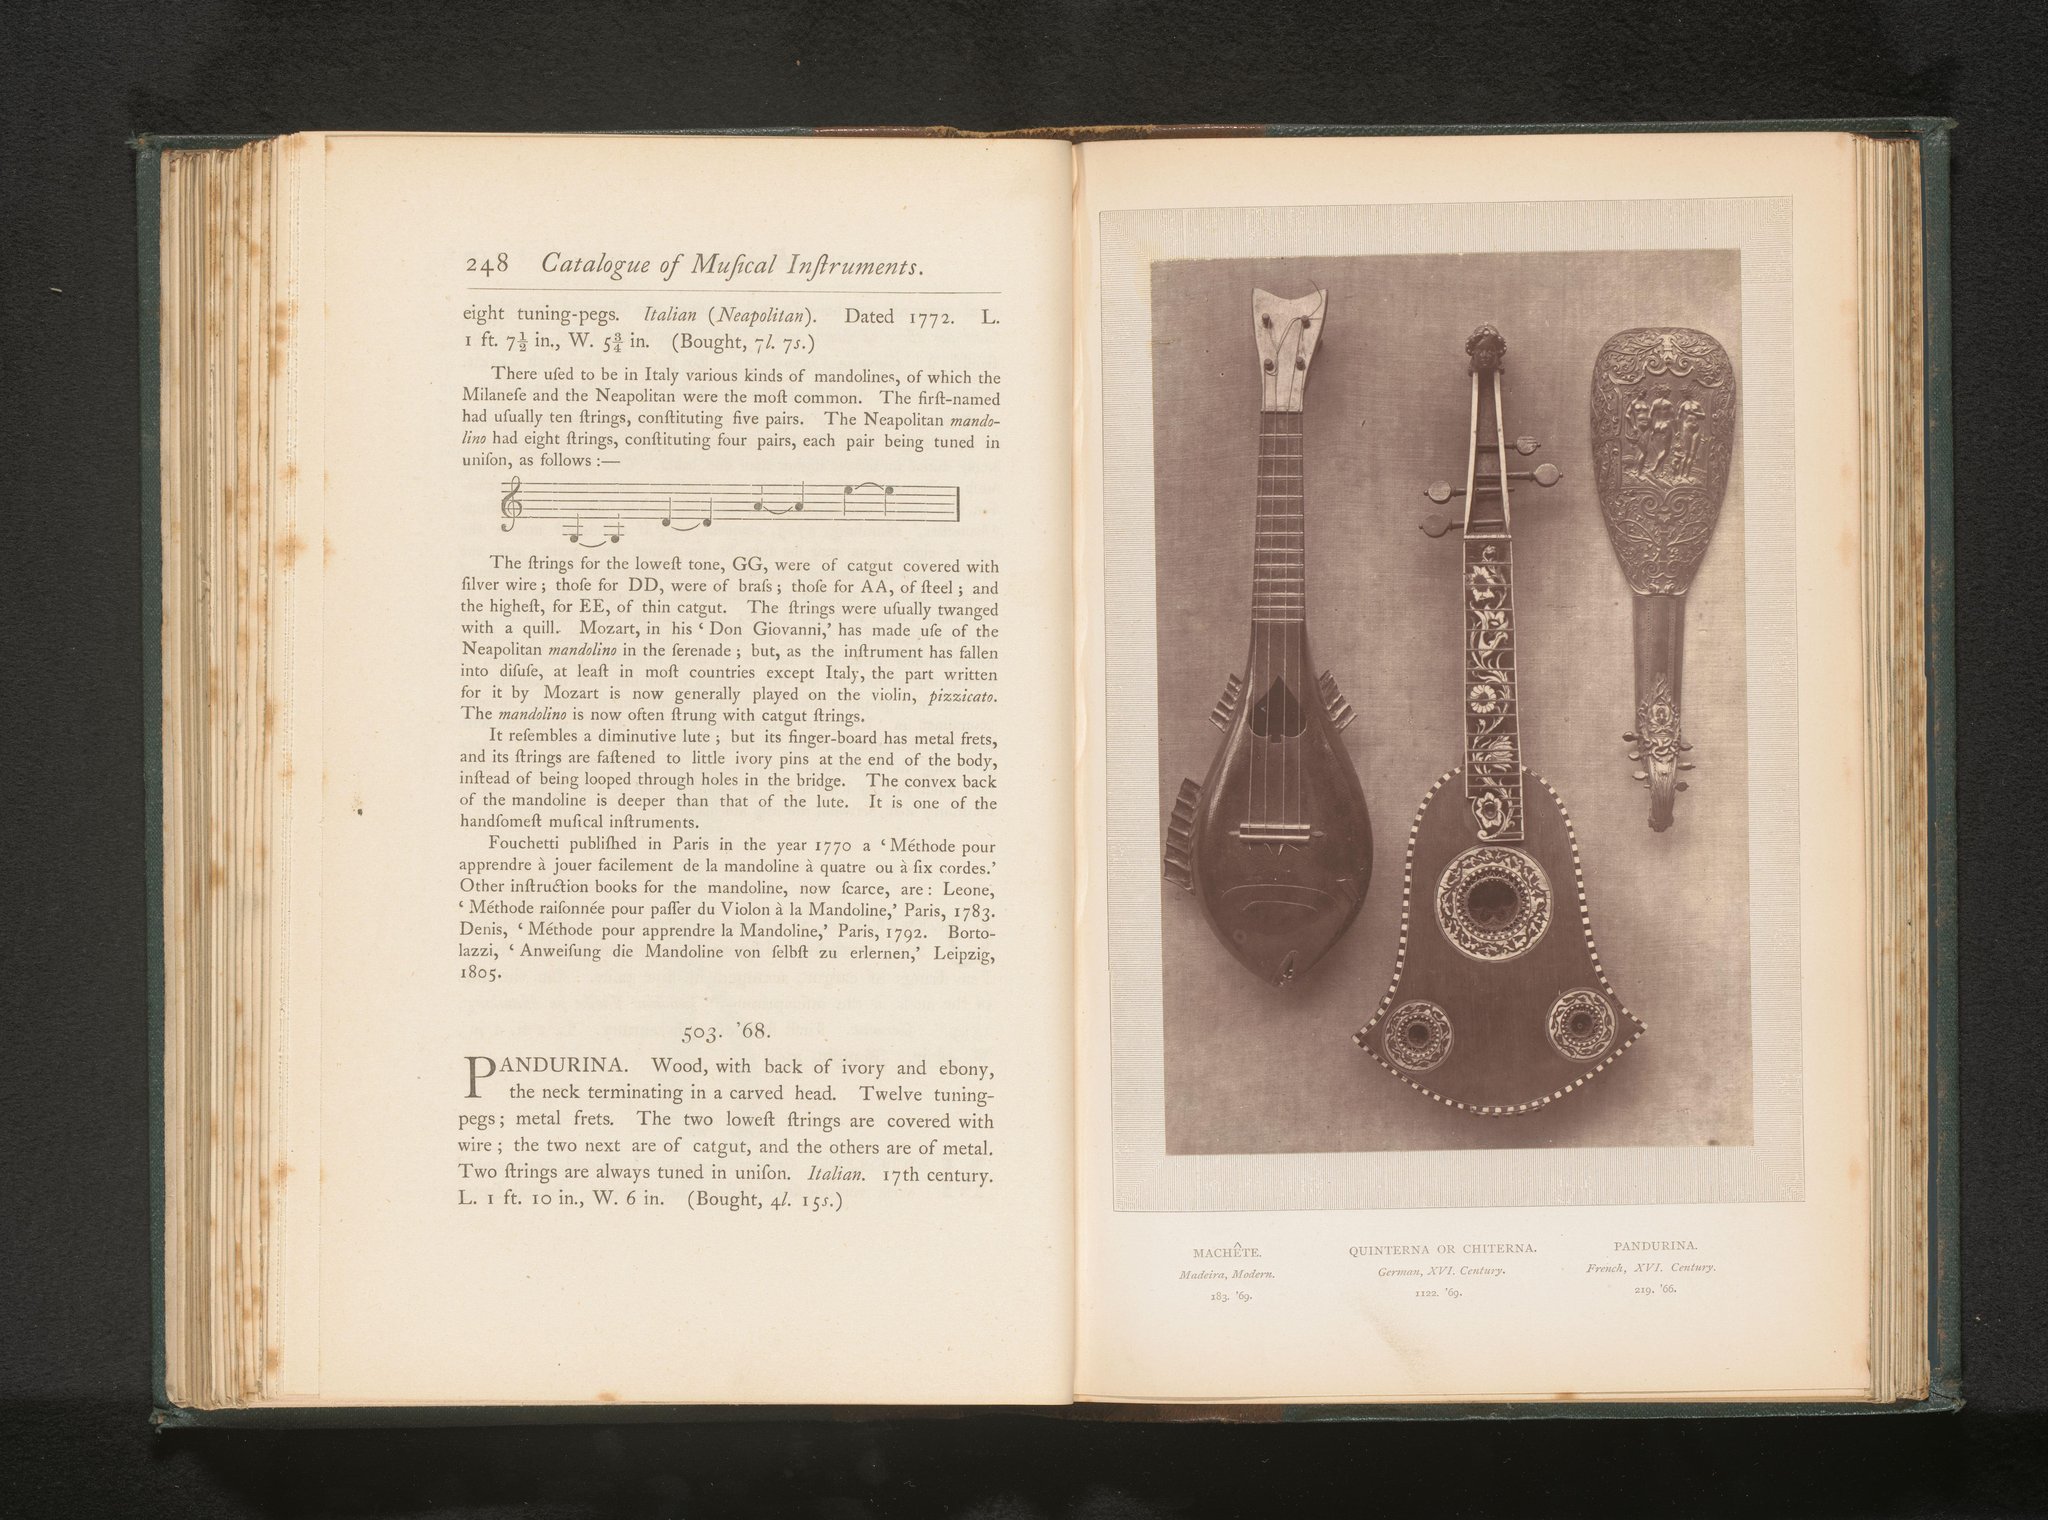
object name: page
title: Opstelling van een machete, een citer en een pandurina van het South Kensington Museum te Londen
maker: Anonymous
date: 1869-1874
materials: paper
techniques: woodburytype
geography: london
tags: string instruments (plucked), cithern, mandolin, guitar, balalaika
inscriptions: inscription: ‘machête (...) 219. '66.’